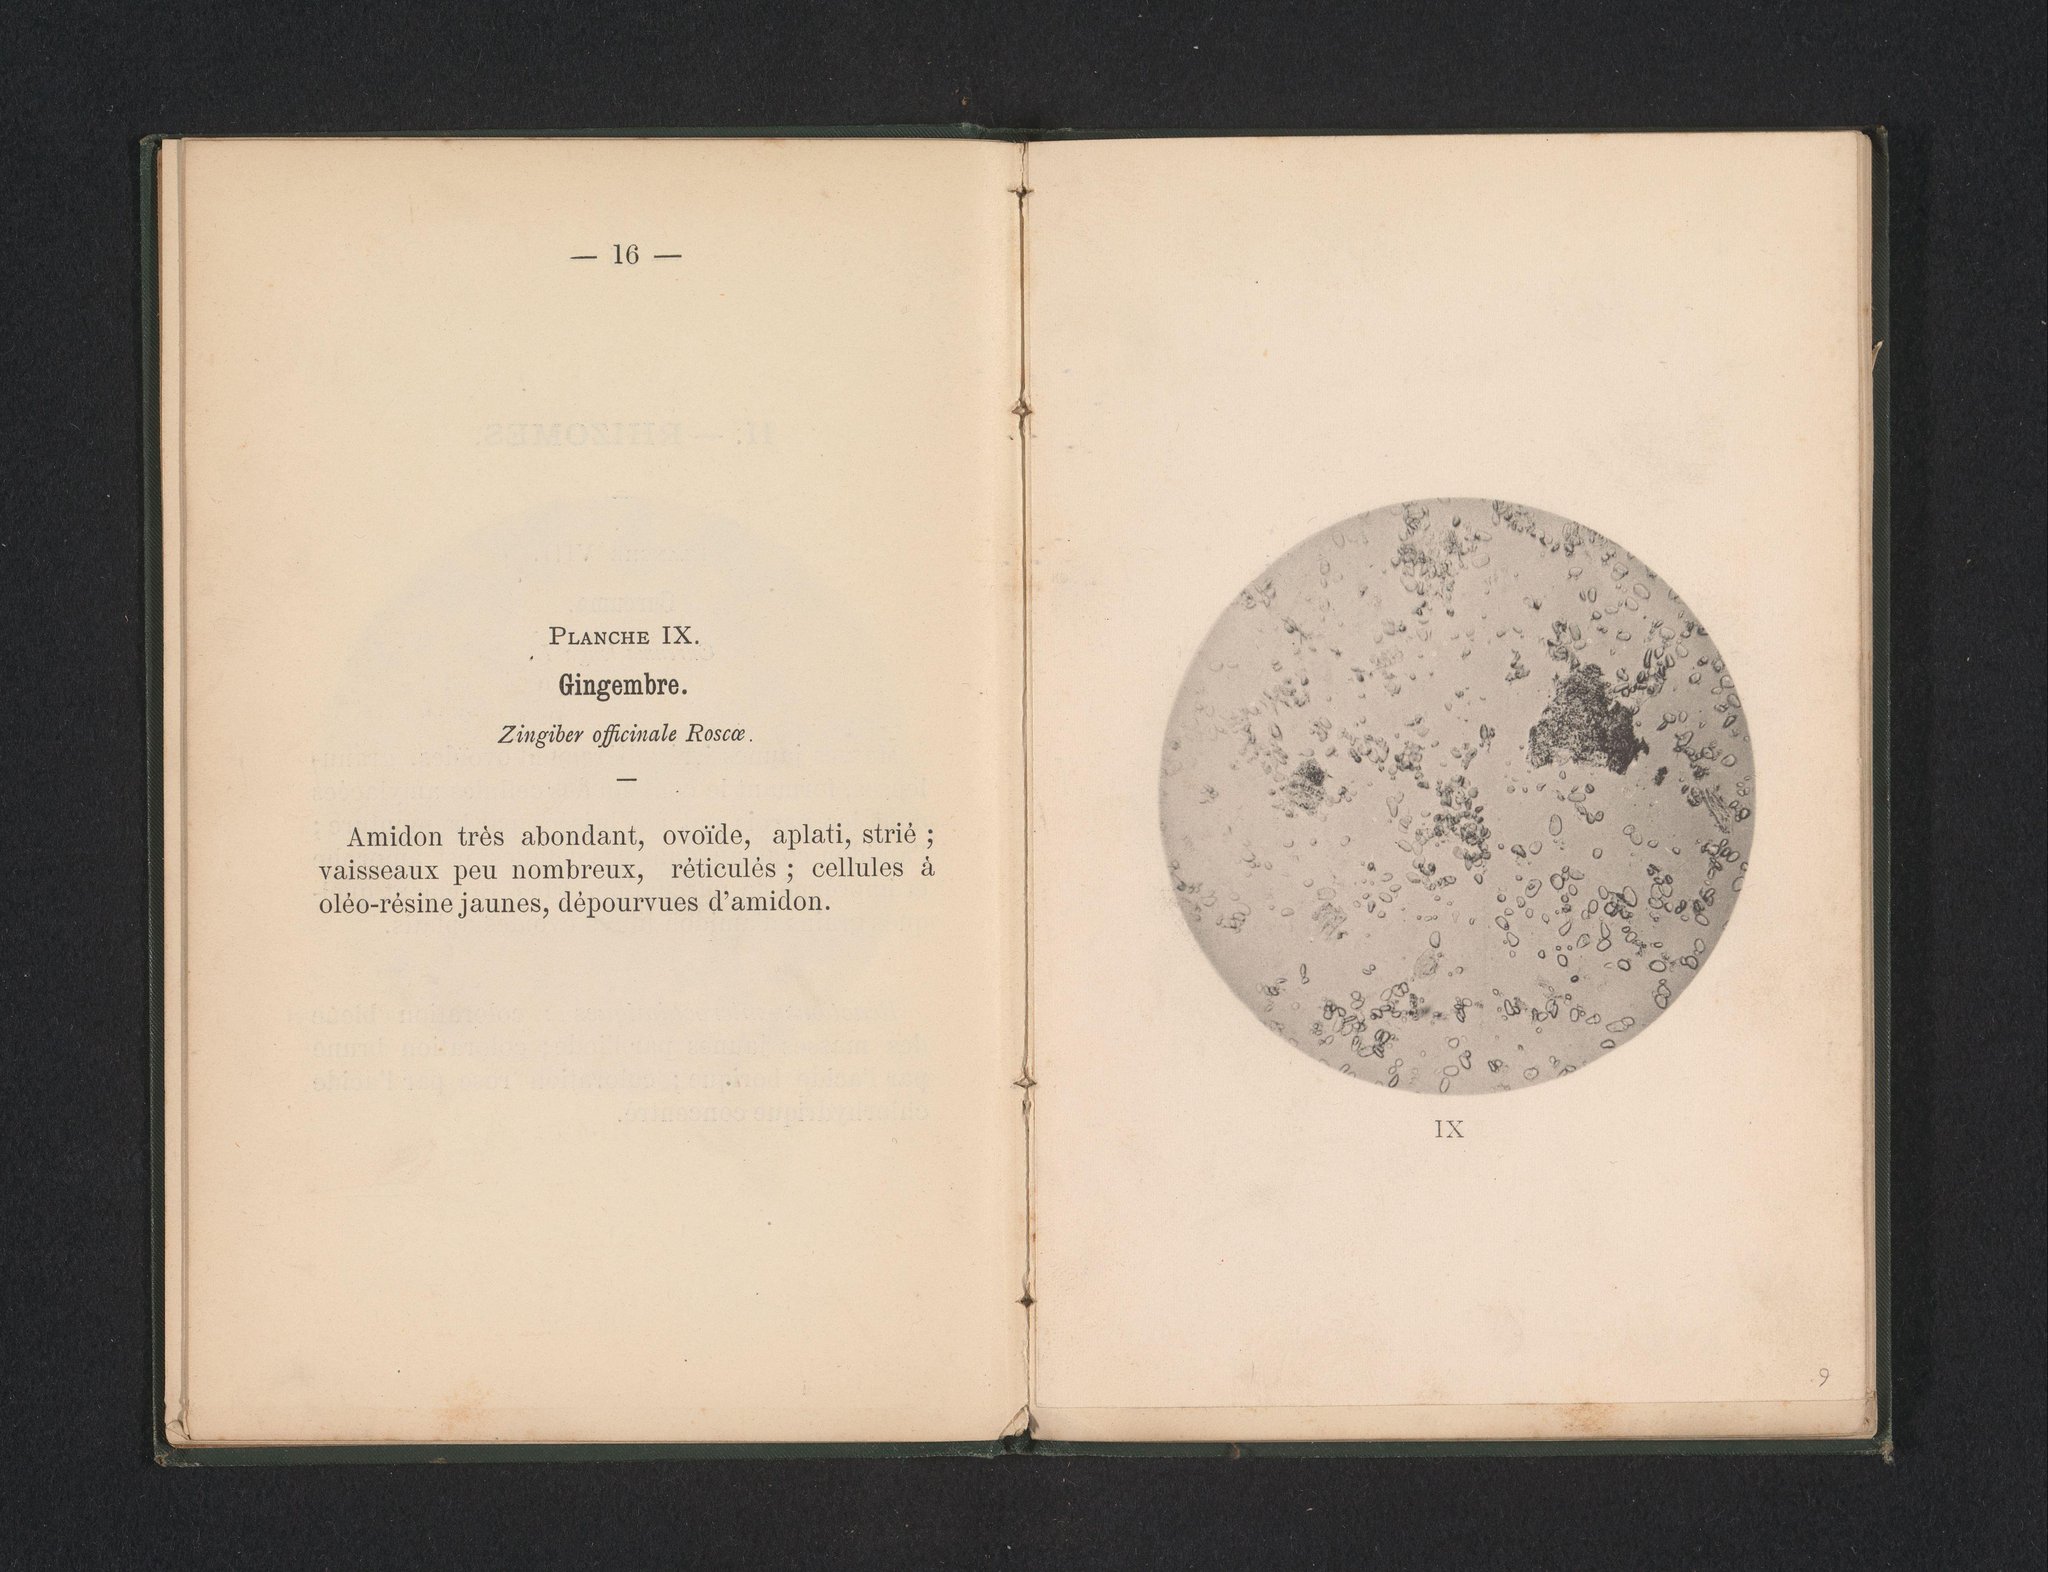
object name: photomechanical print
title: Microscopische weergave van gember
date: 1891-1896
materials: paper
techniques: photograph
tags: microscope (+ scientific research)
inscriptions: number: ‘IX’